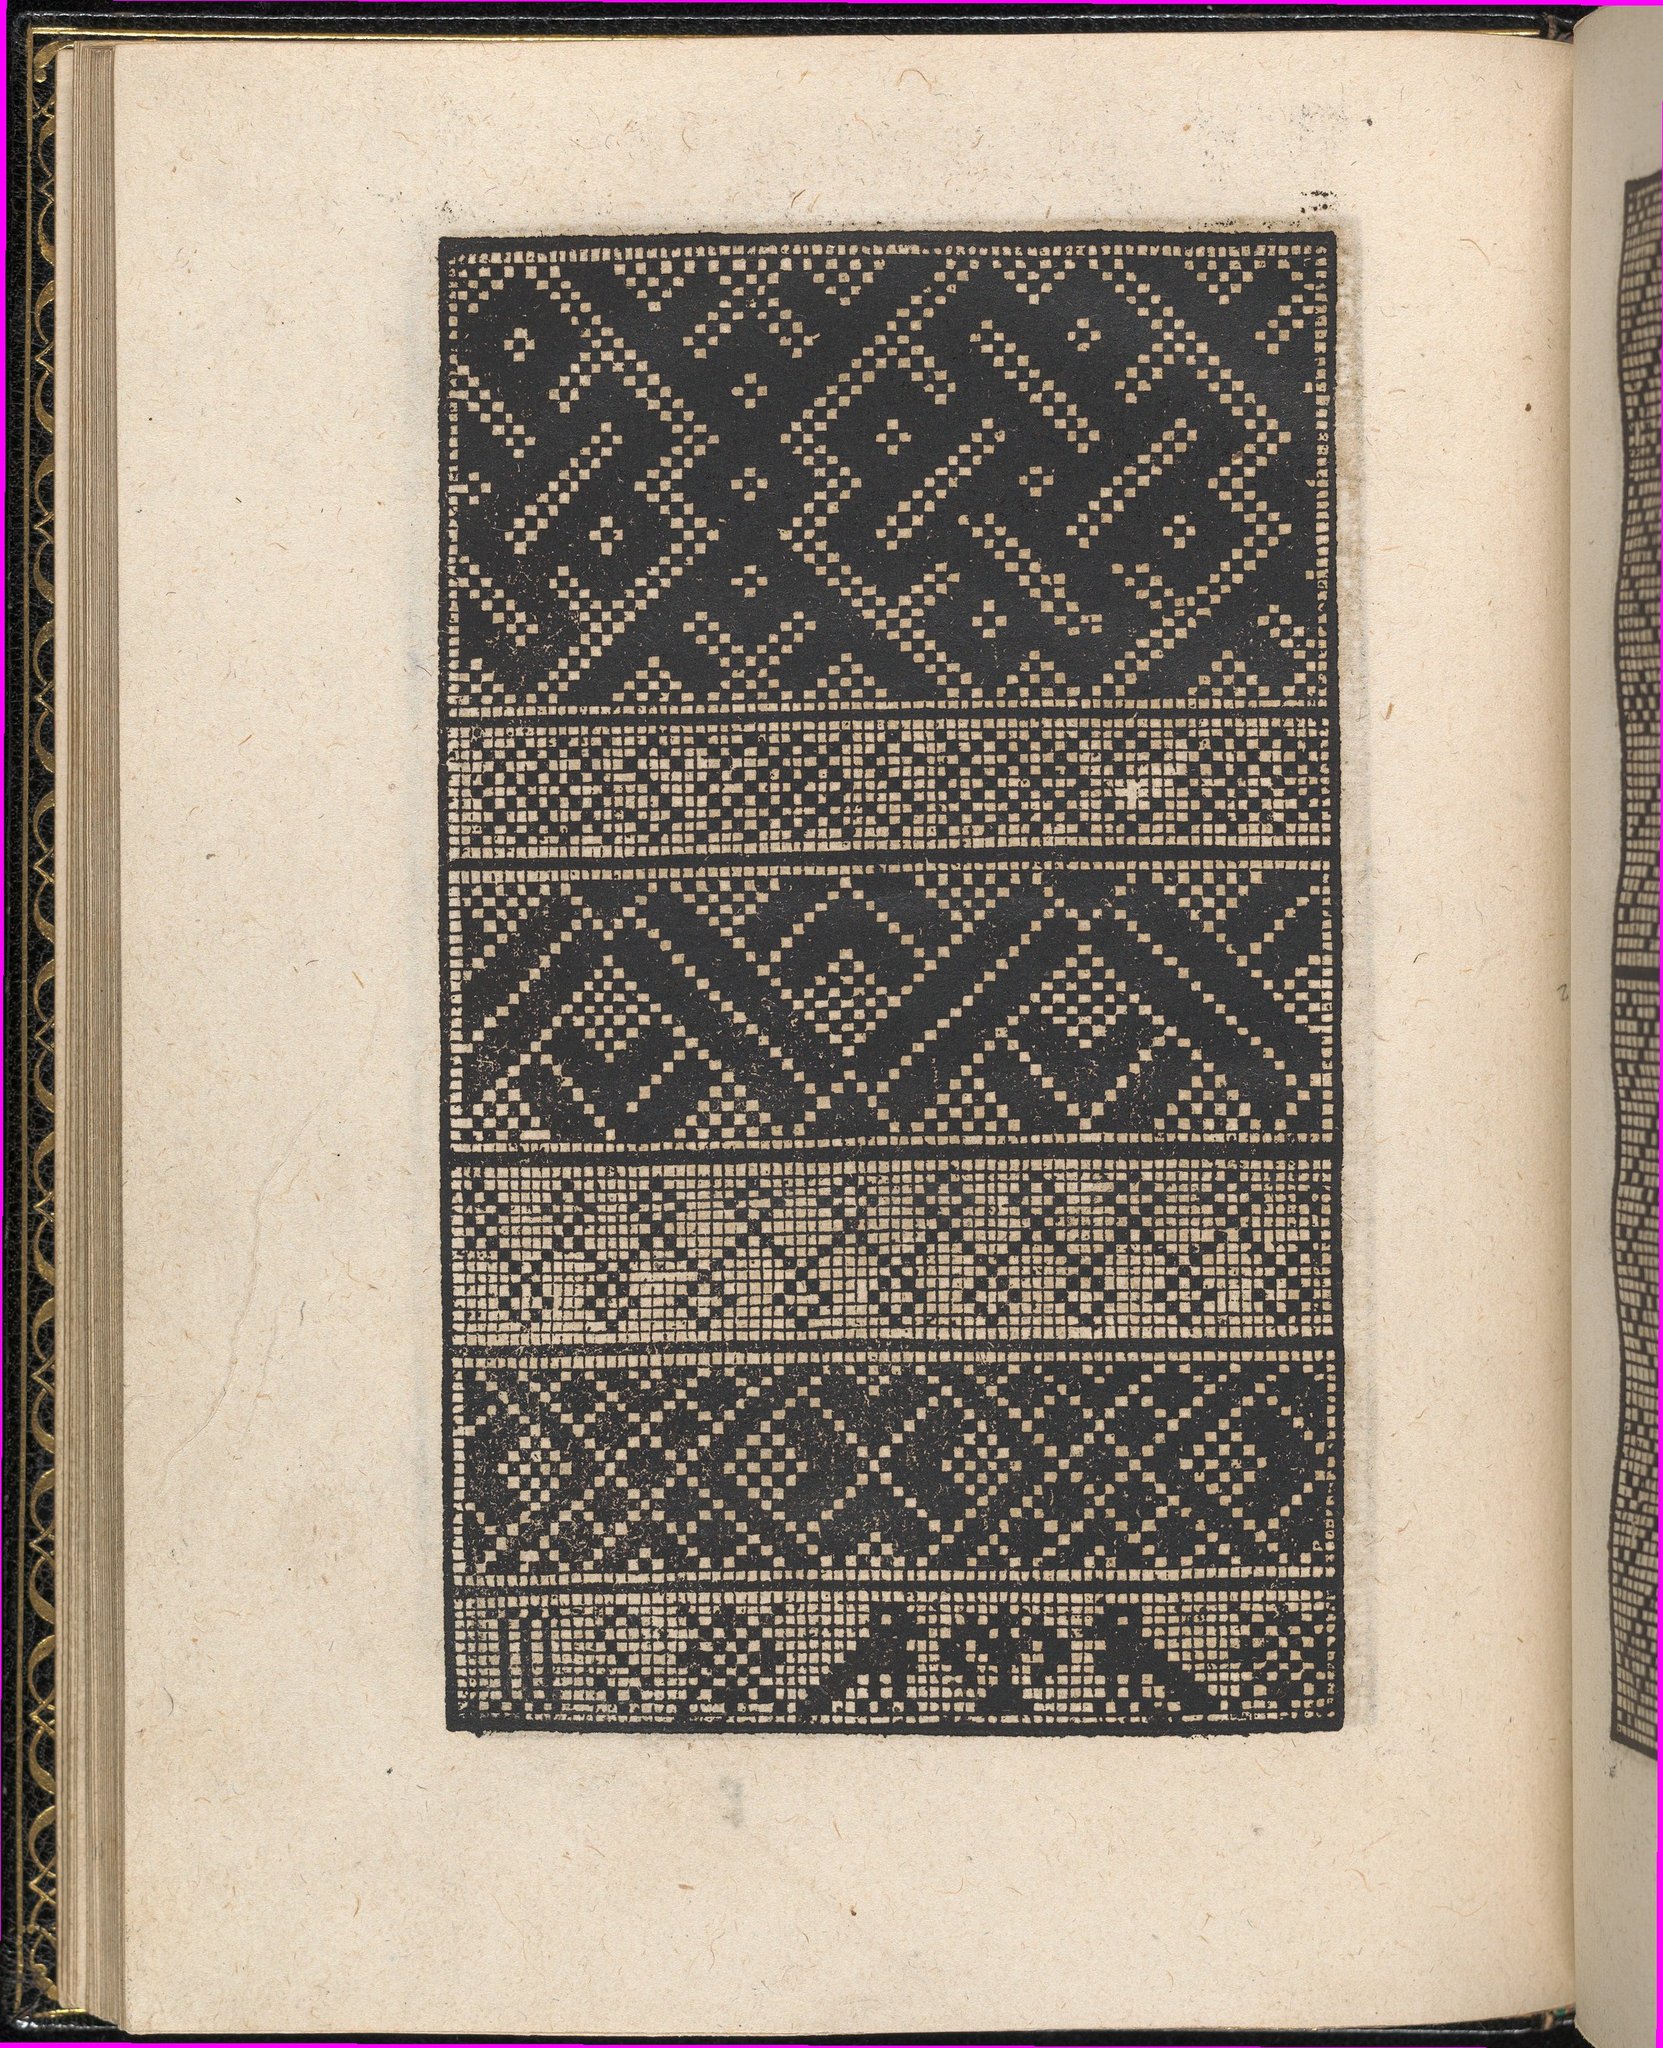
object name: book print ornament architecture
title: Page from Ein new kunstlich Modelbuch...(Page 24v)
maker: peter quentel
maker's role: publisher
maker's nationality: german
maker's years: 1500-1550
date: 1544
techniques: woodcut